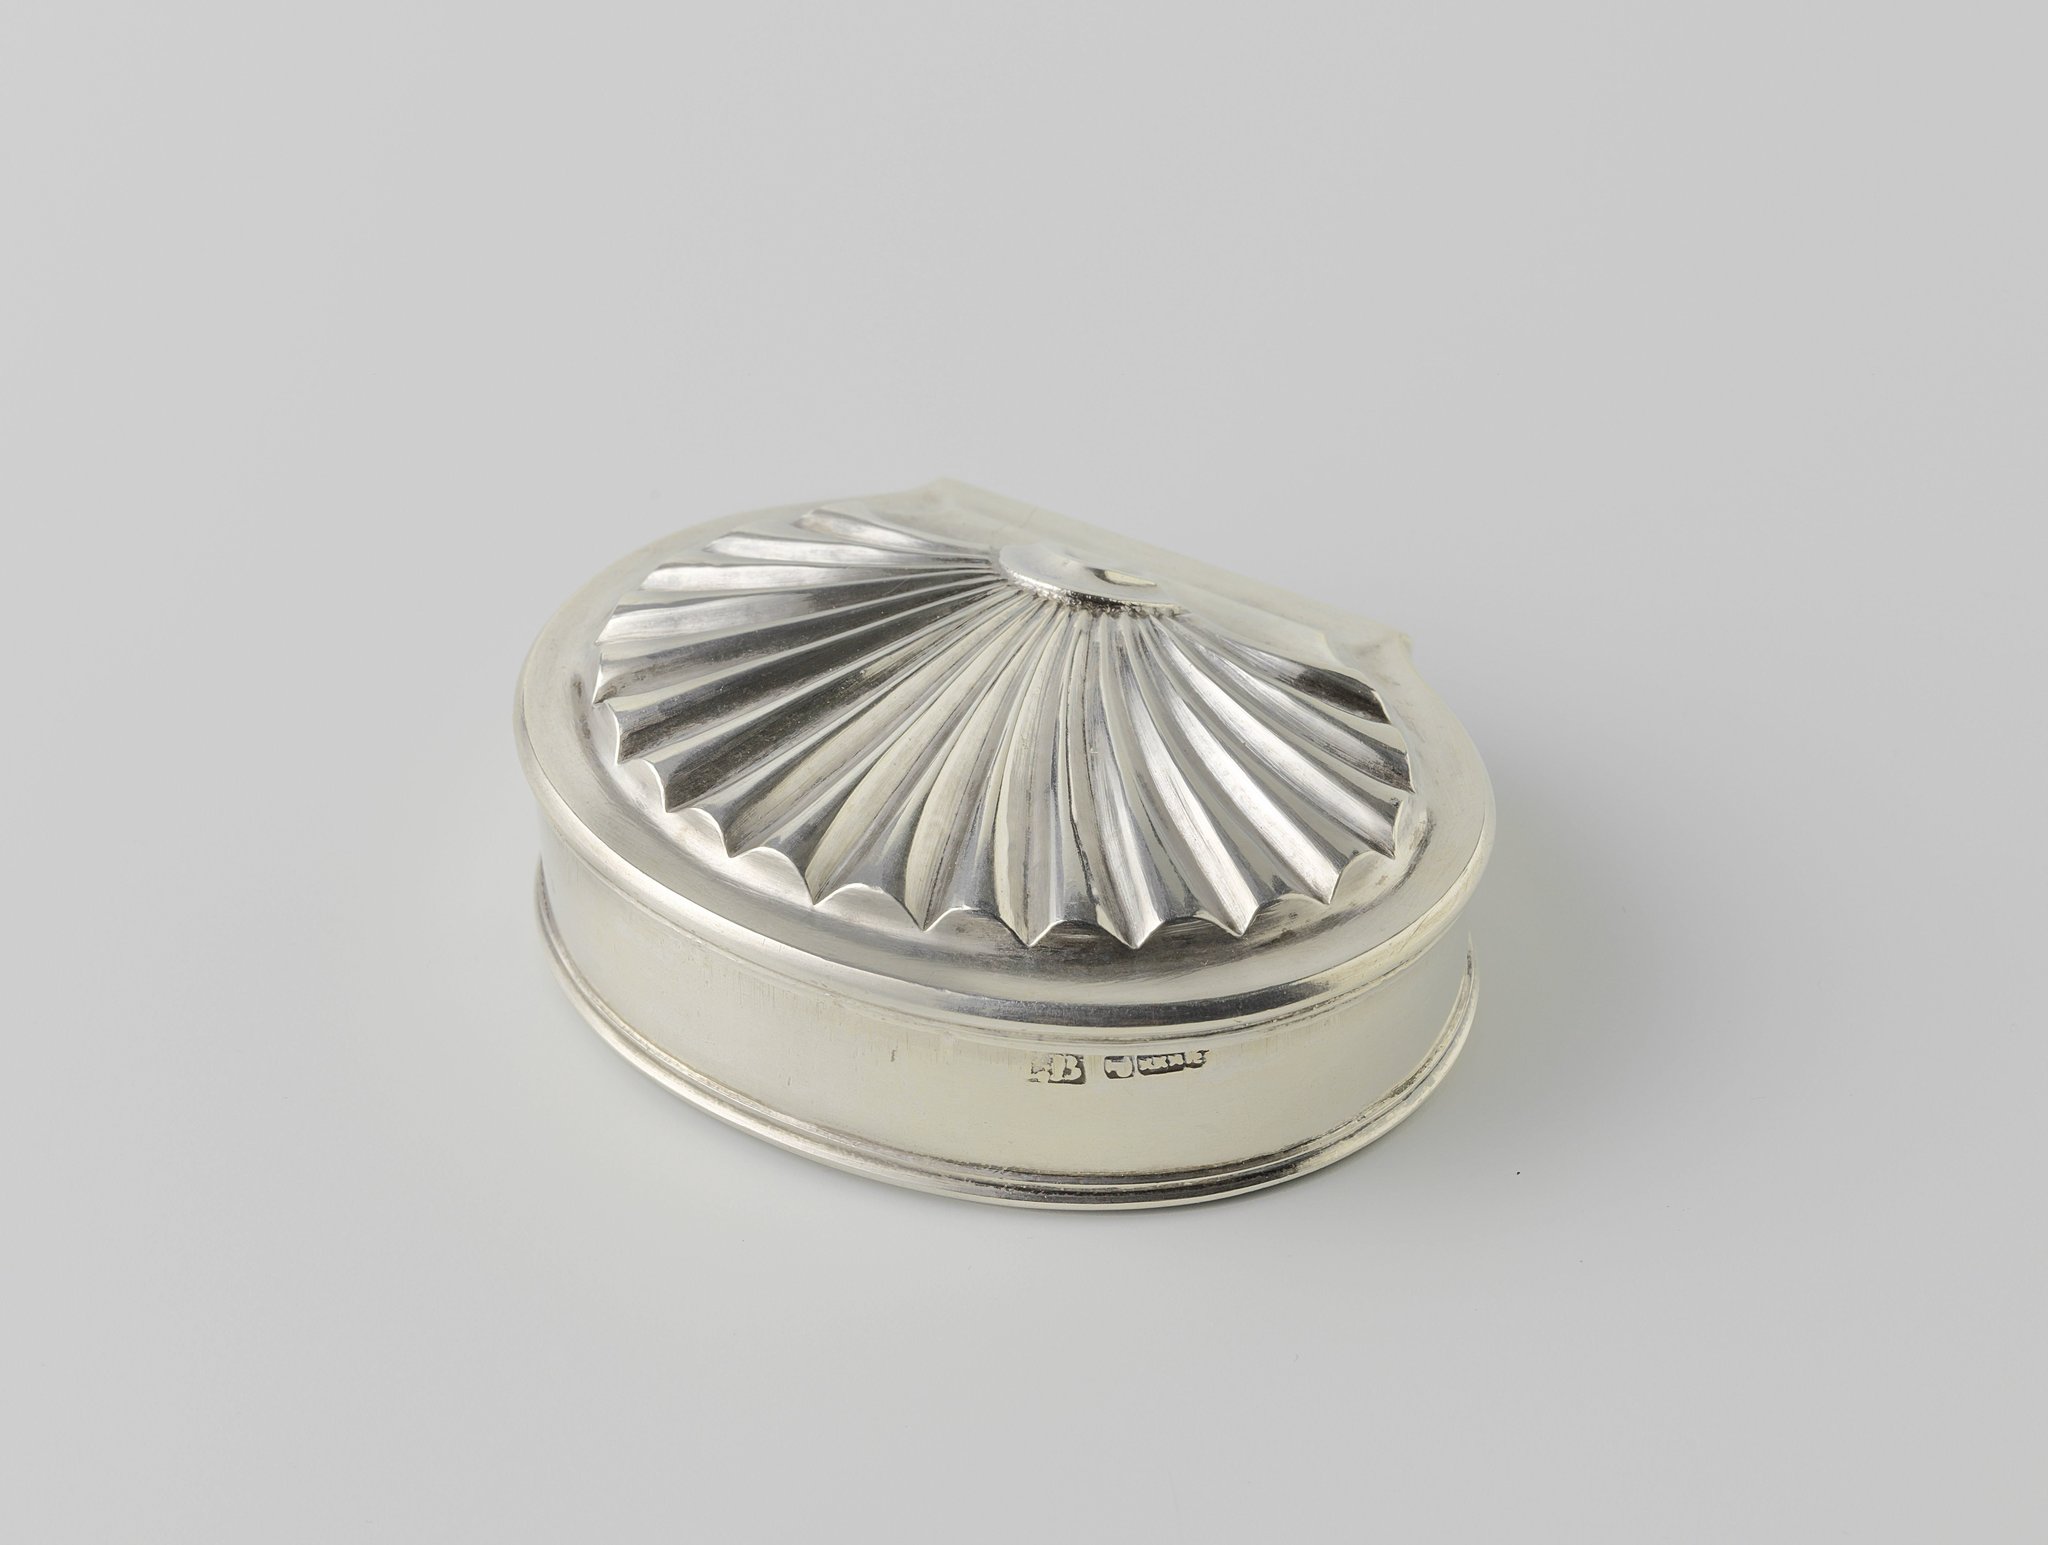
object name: box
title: Snuifdoos, schelpvormig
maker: leendert beekhuysen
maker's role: silversmith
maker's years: 1708-1771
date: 1749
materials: silver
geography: amsterdam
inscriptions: maker's mark, date letter: ‘P’, town mark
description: Snuifdoos van zilver. De schelpvormige doos, met een rechte achterzijde, heeft een scharnierend deksel. Hierop is binnen een vlakke rand een schelp gedreven. Langs de onderrand van de doos en langs het deksel lopen profielranden. Aan de onderzijde van de doos zijn de letters I.E.D. gegraveerd.